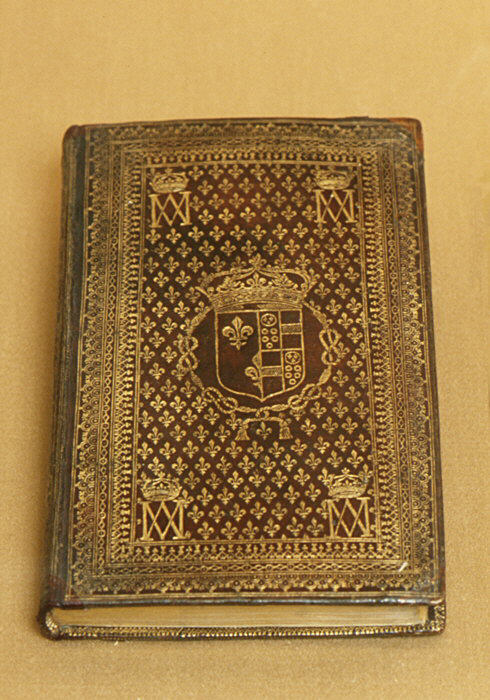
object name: book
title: Les Adventures Amoureuses de Theagenes et Cariclée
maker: heliodorus, of emesa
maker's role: author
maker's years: 200-300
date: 1613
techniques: etching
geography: france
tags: insignia